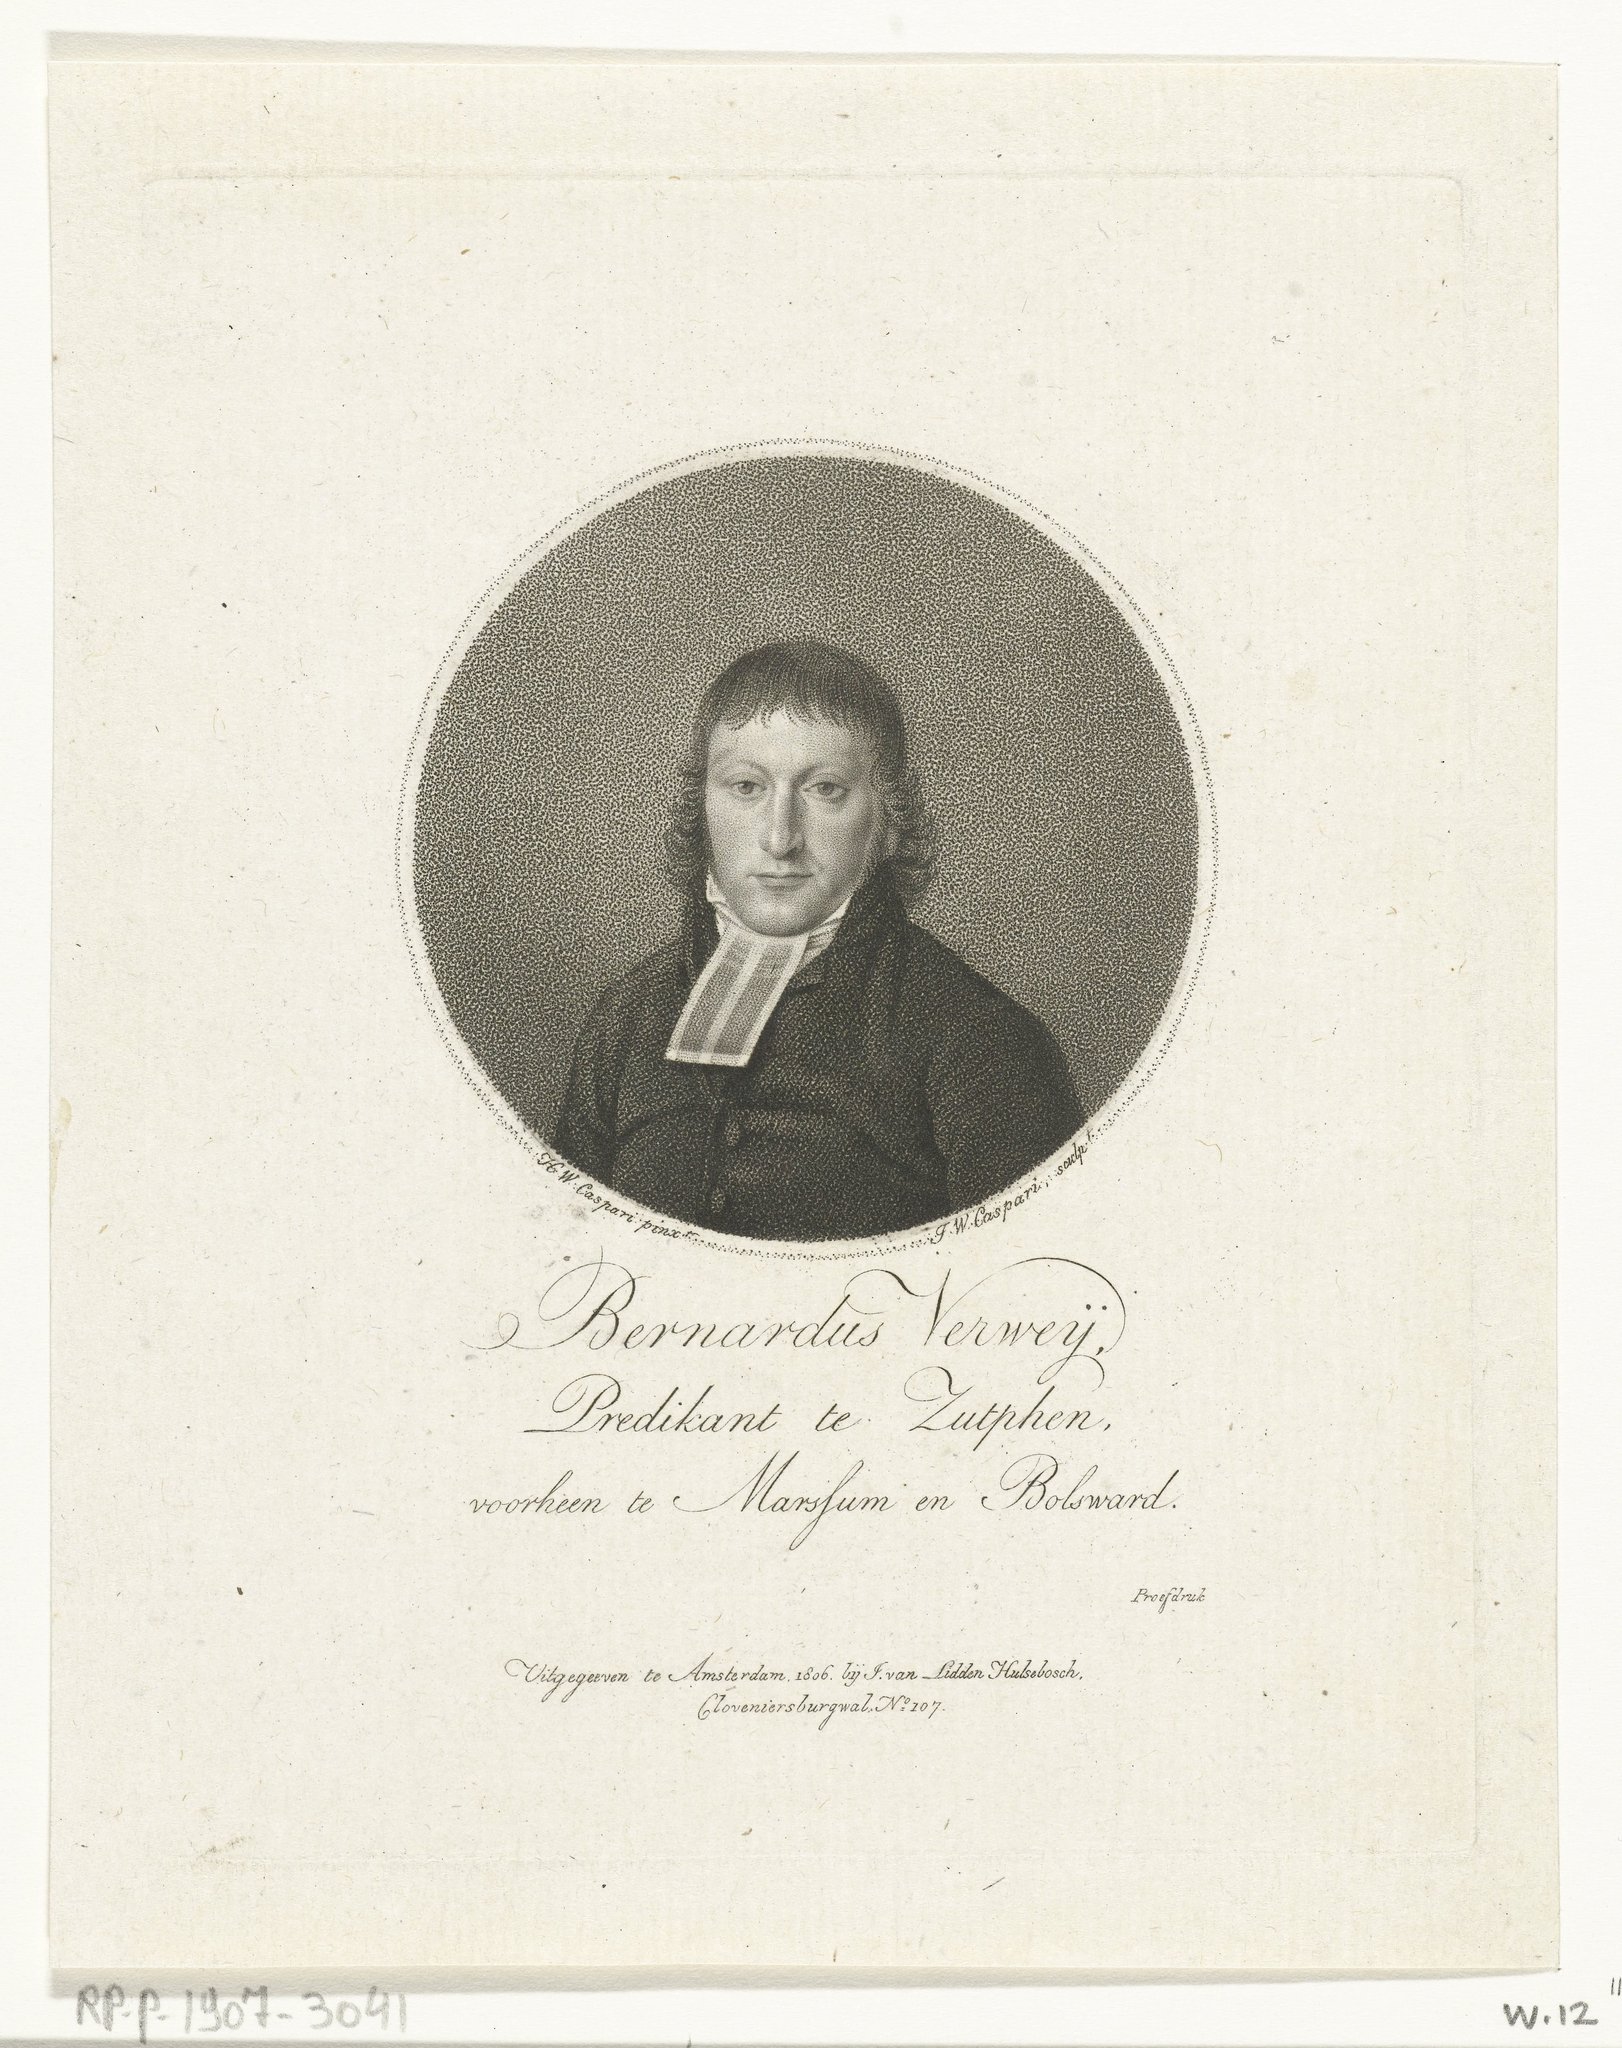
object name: print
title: Portret van Bernardus Verwey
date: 1789-1822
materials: paper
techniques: etching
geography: amsterdam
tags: bernardus verwey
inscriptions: collector's mark: Lugt 2228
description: Portret in ronde lijst van Bernardus Verwey, predikant te Den Haag en Zutphen. Buste frontaal. Verwey heeft een zwarte toga aan met een witte bef. De prent heeft een Nederlands onderschrift met naam van de geportretteerde.